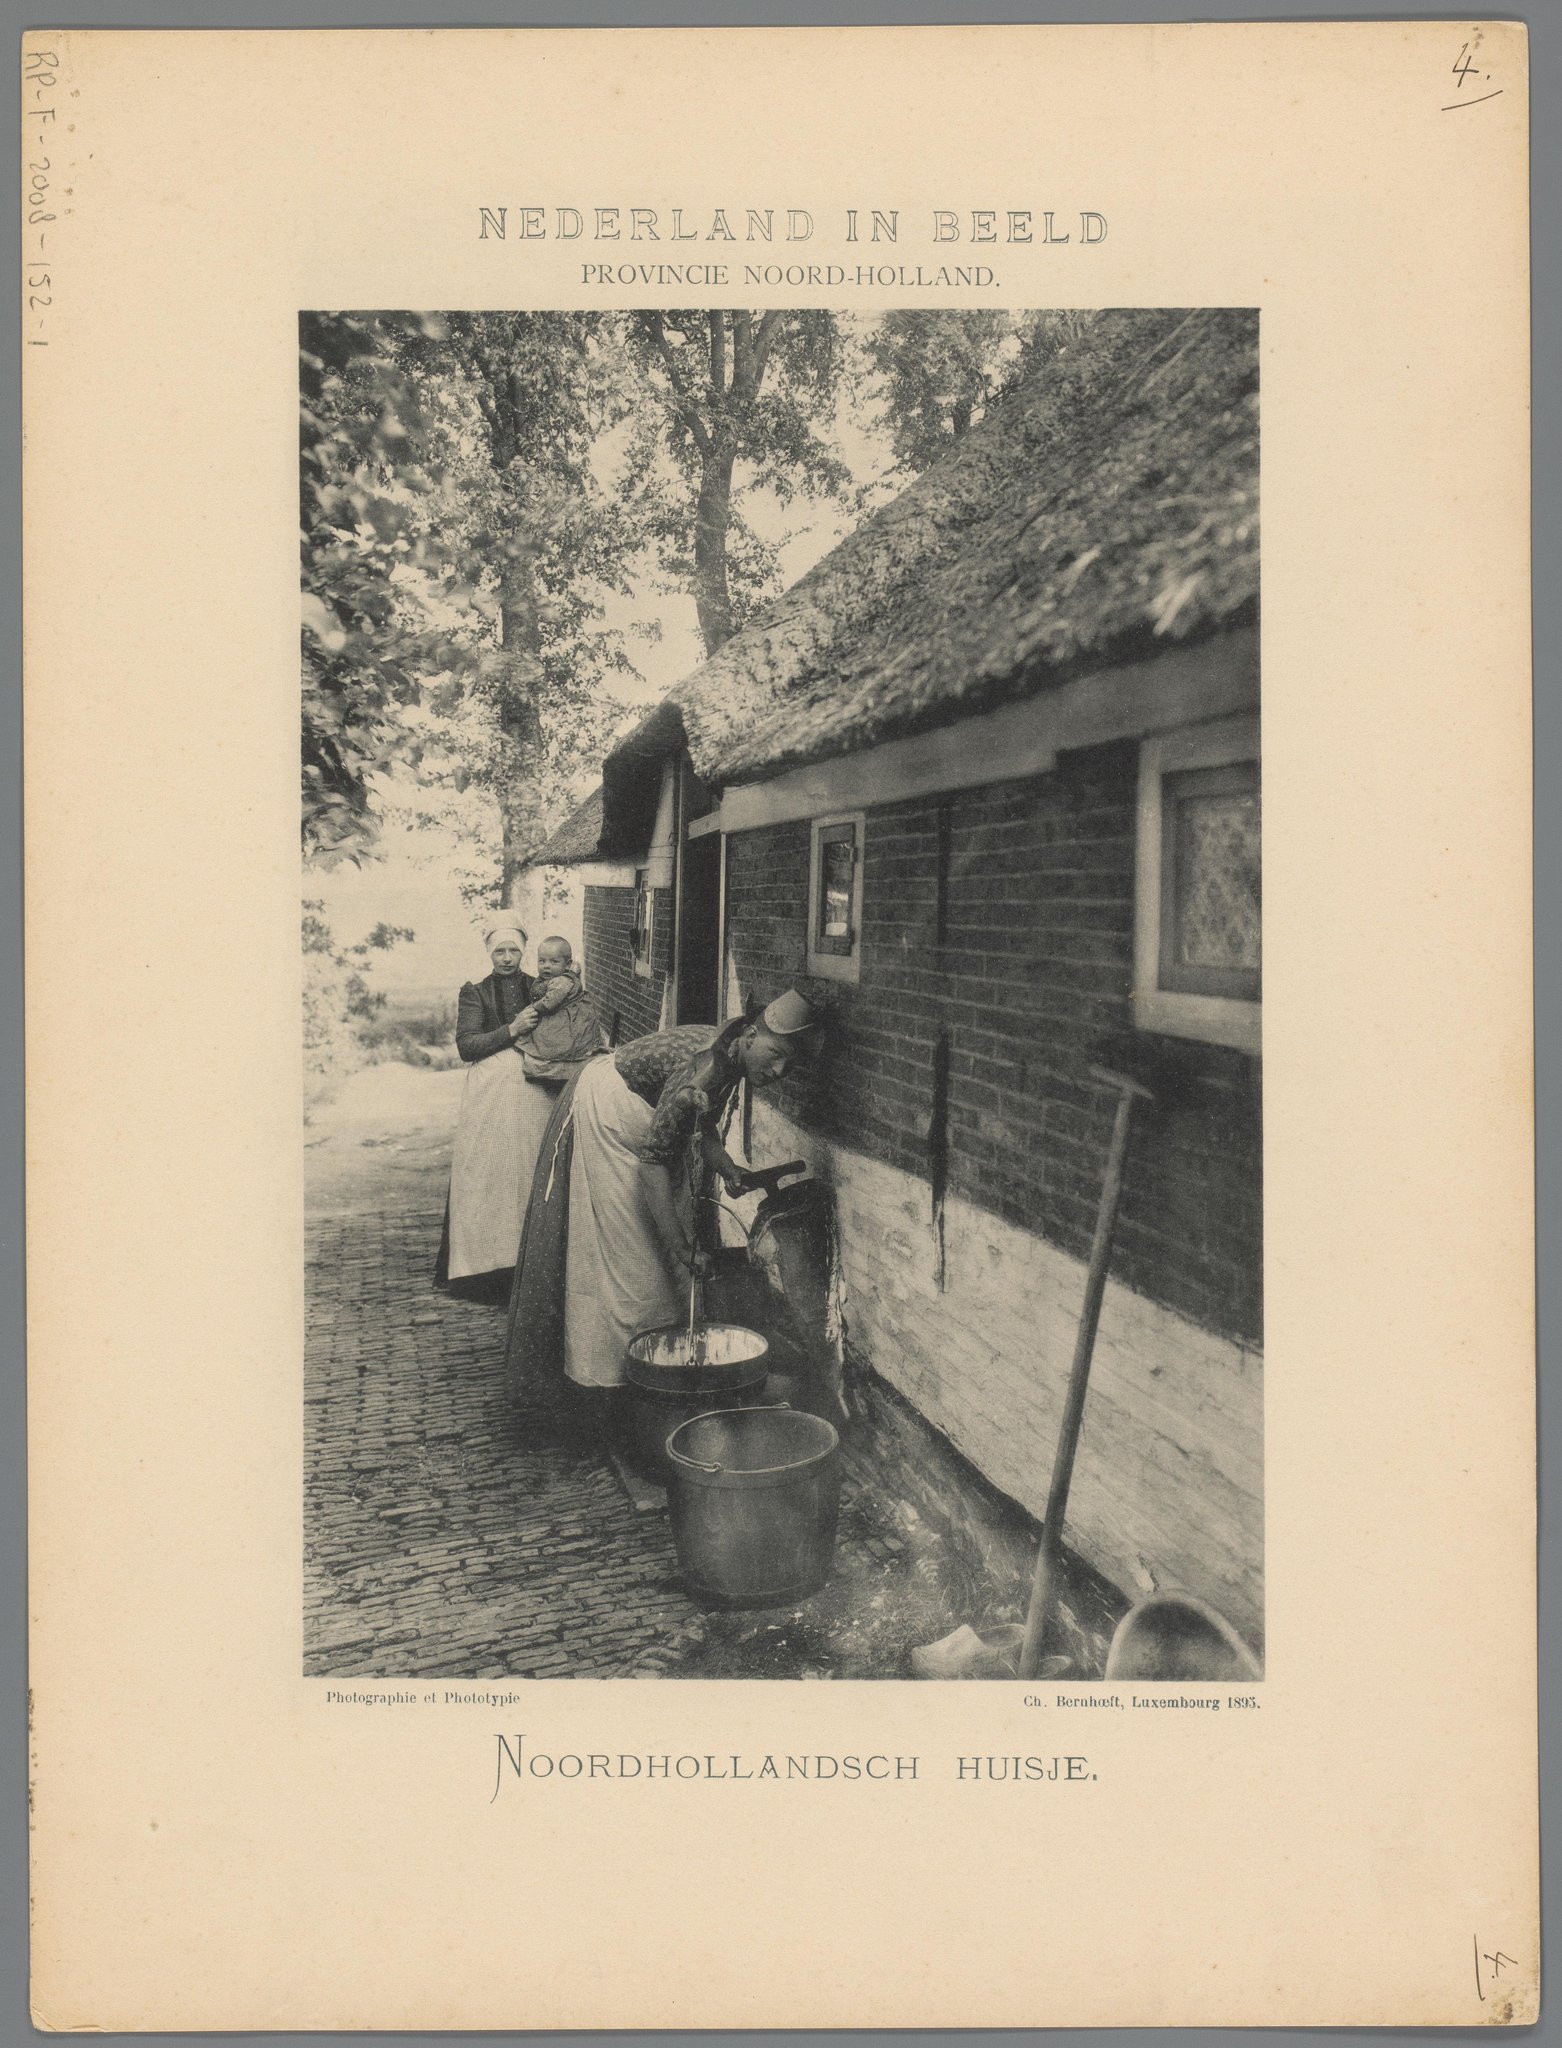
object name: photomechanical print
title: Twee vrouwen en een kind naast een huis in Noord-Holland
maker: charles bernhoeft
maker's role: publisher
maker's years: 1859-1933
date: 1893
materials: cardboard, paper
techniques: photograph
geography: netherlands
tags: historical persons, laundering, mother and baby or young child, exterior ~ representation of a building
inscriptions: number: ‘4.’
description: Deze prent maakt deel uit van een omslag met 43 lichtdrukken op 43 bladen.